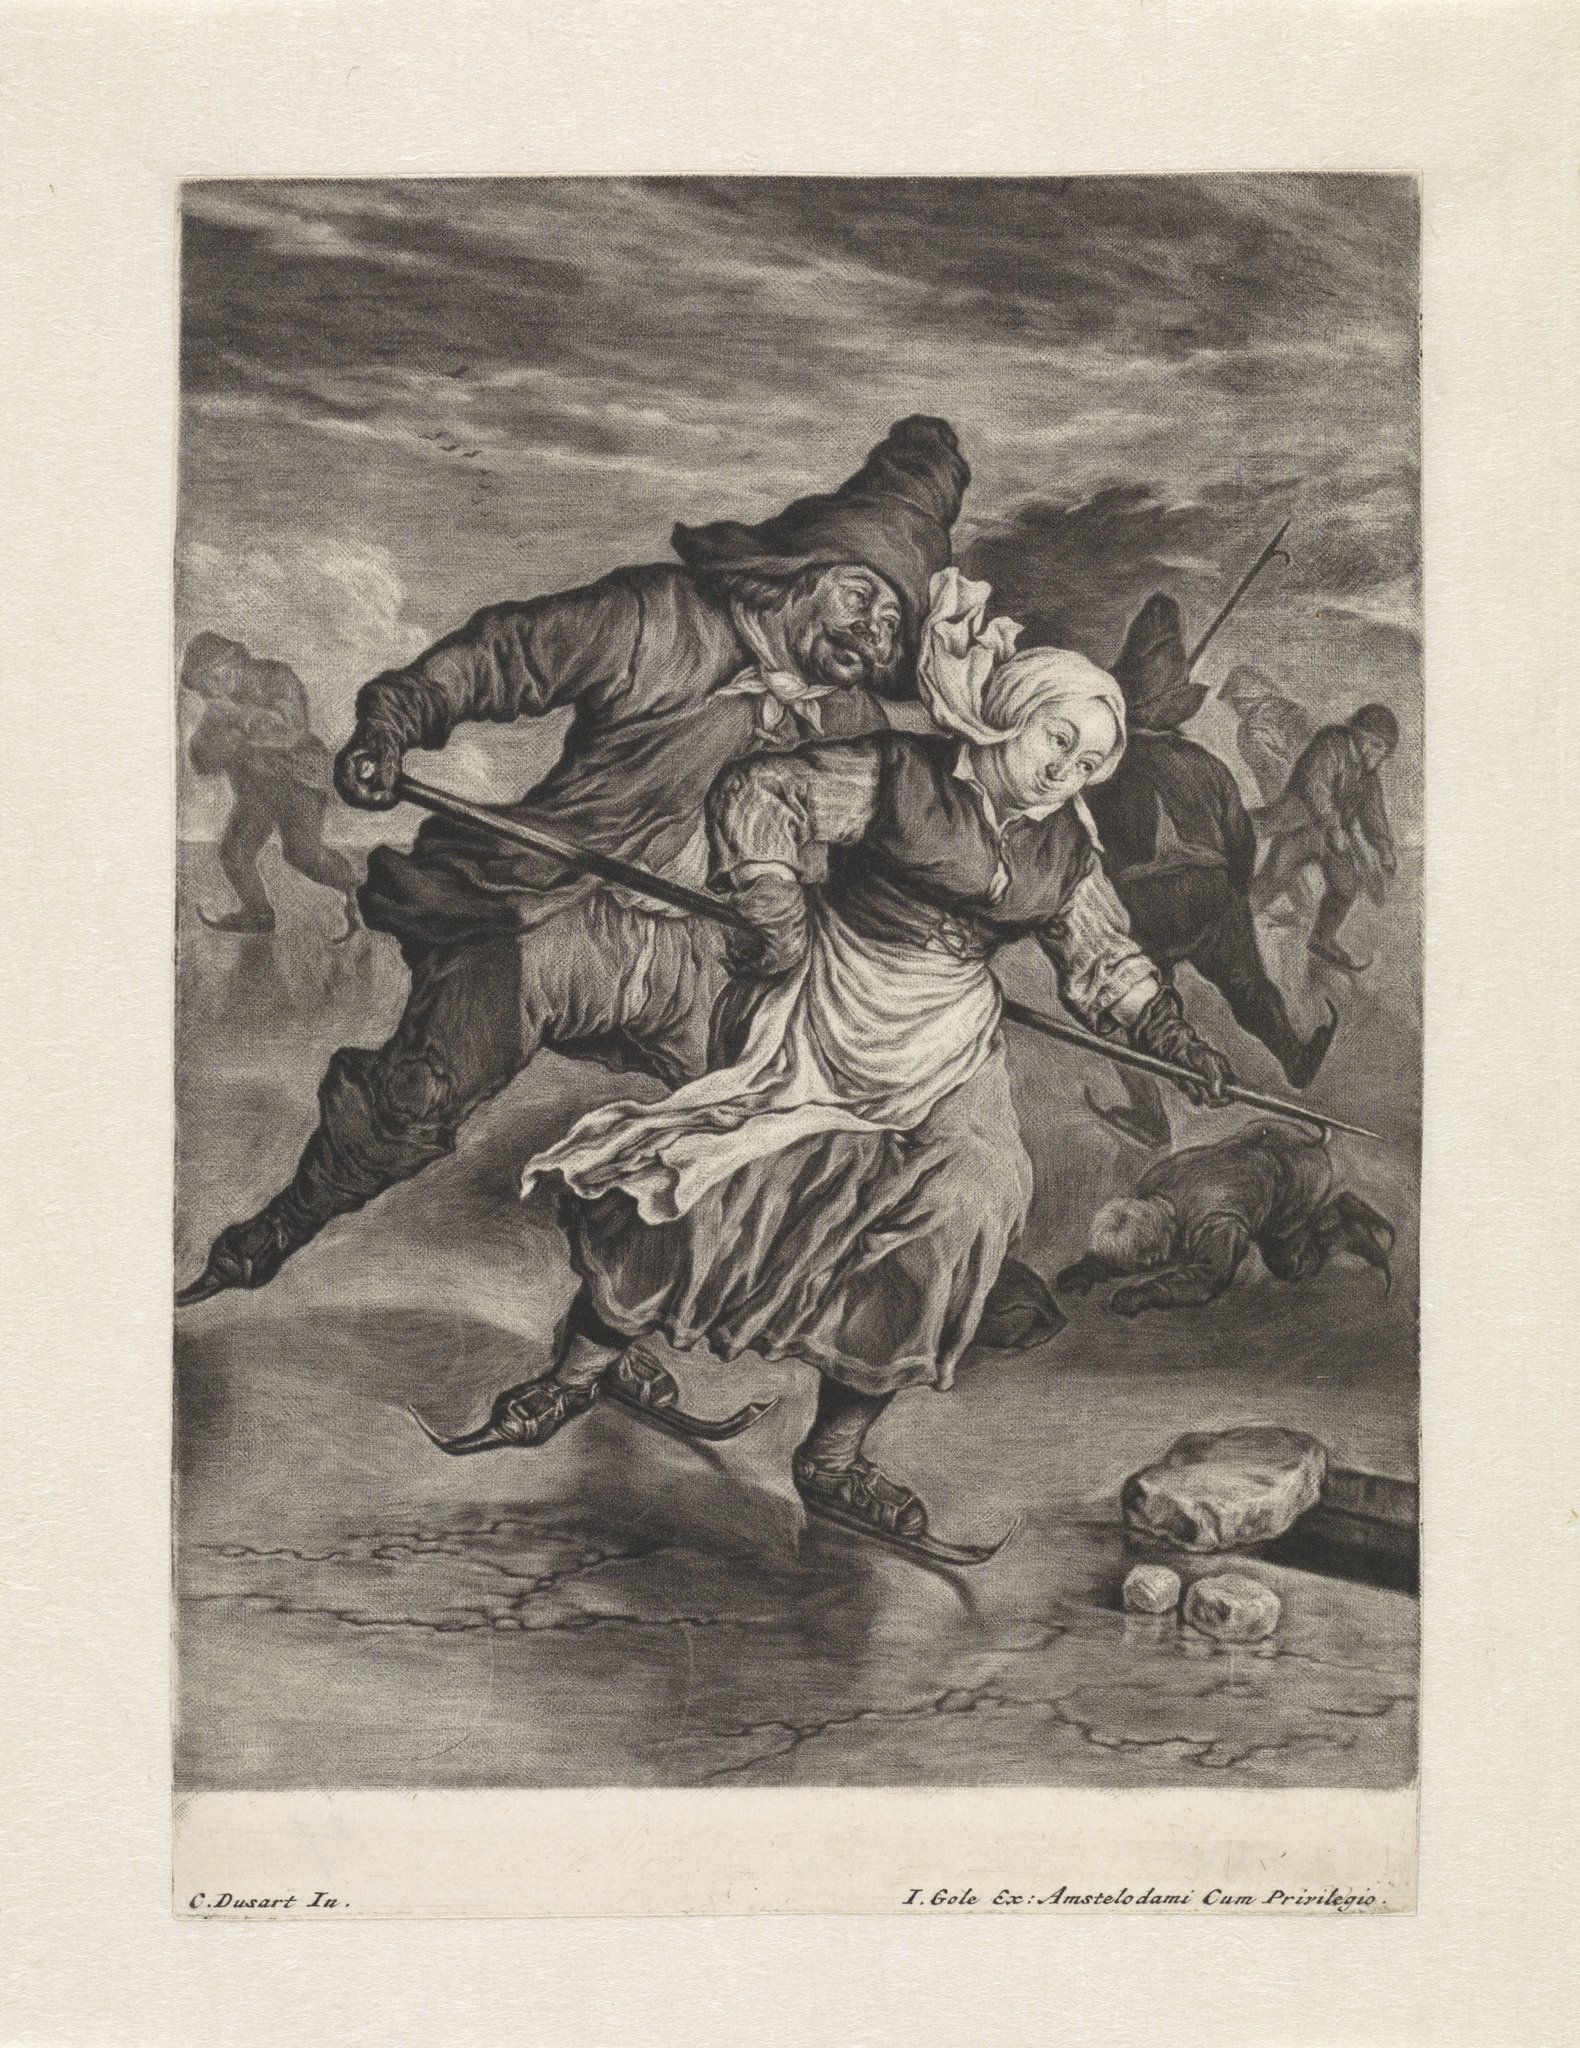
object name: print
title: December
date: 1679-1704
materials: paper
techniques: engraving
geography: haarlem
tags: december and its 'labours', skates (winter sports)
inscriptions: collector's mark: Lugt 240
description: IJspret. Een man en een vrouw schaatsen aan een lange stok over het ijs om een wak heen. Op de achtergrond zijn andere schaatsers te zien, waarvan er een gevallen is. De prent maakt deel uit van een serie van twaalf prenten met de twaalf maanden van het jaar.